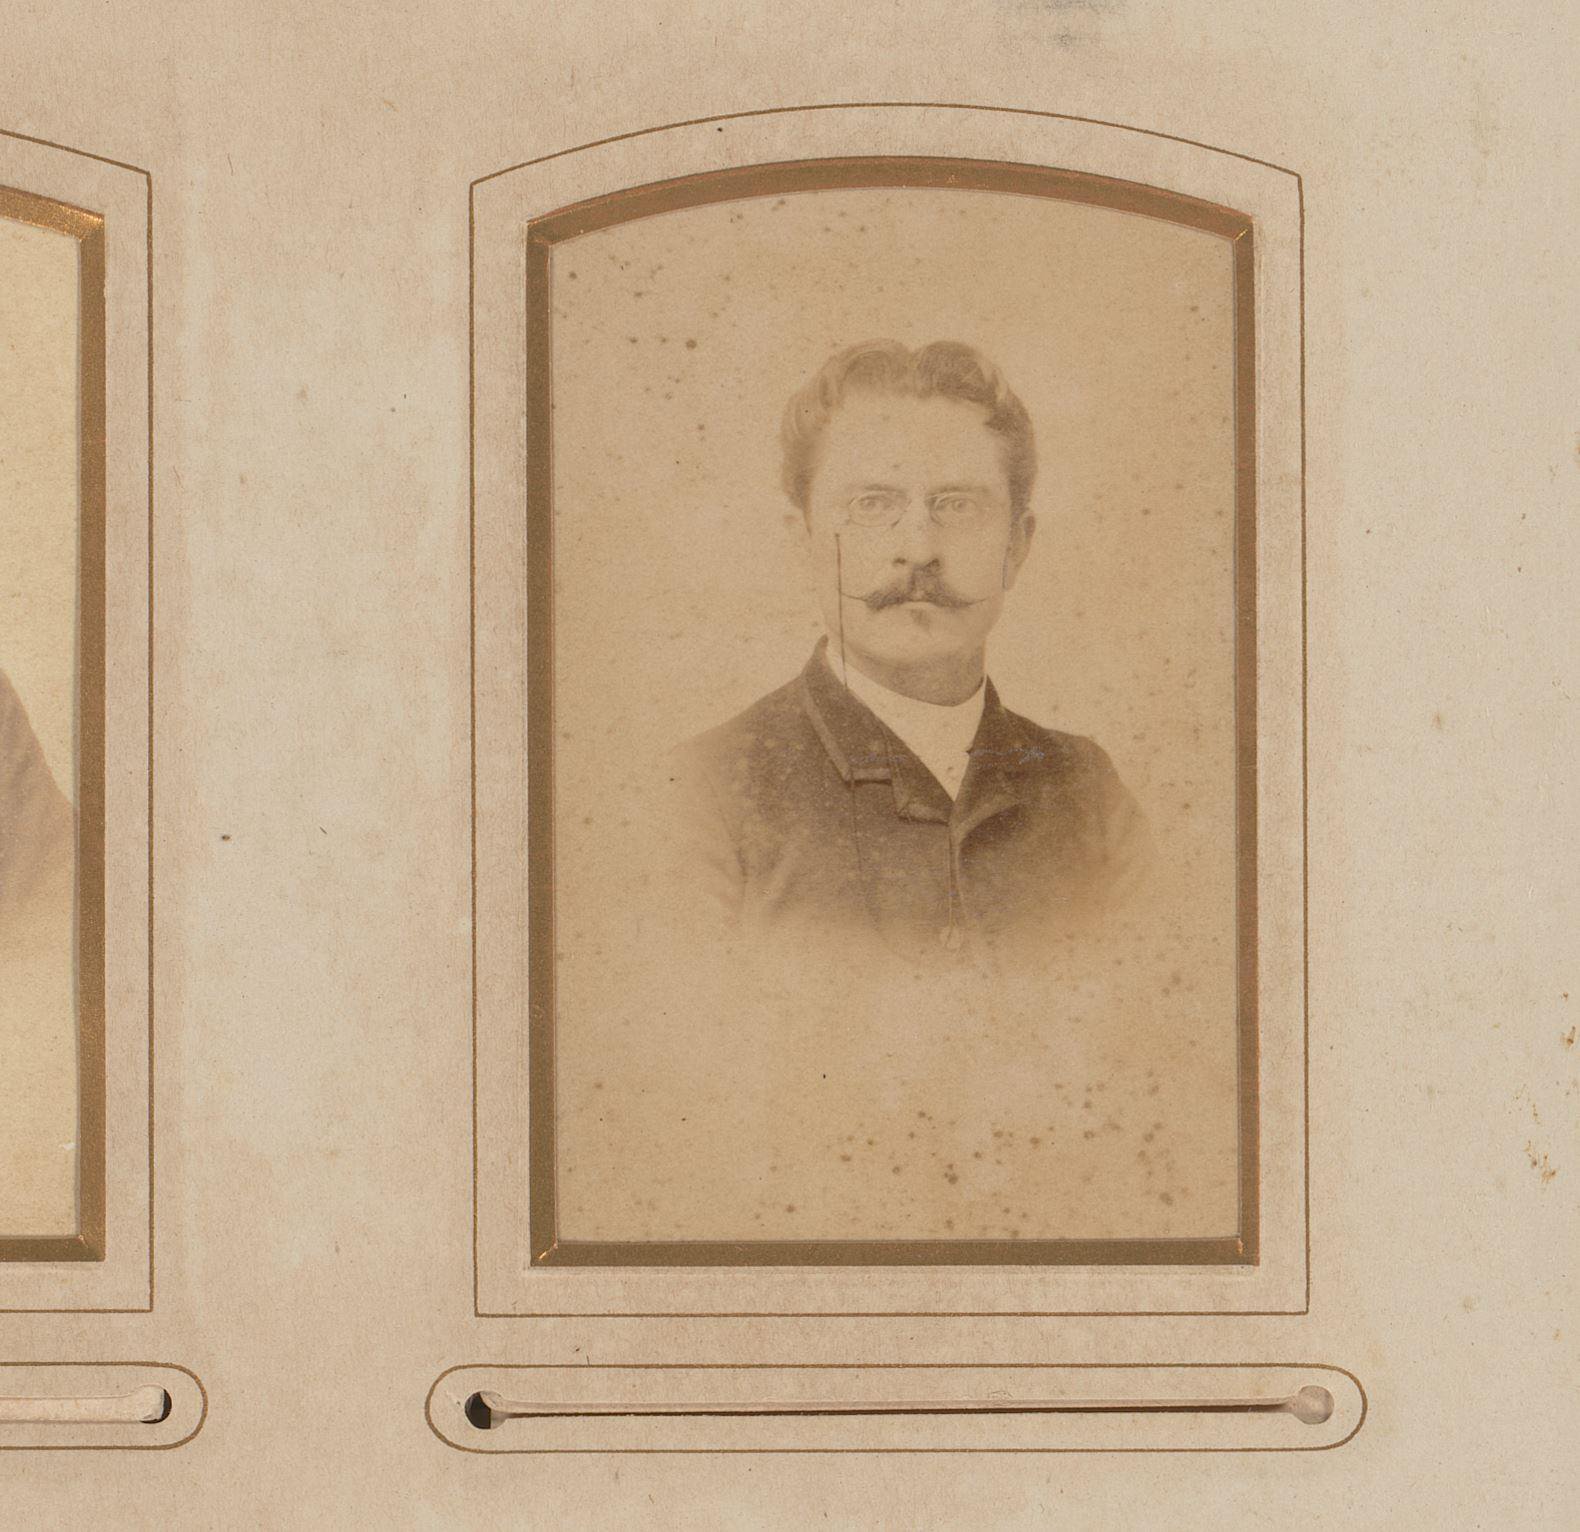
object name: carte de visite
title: Portret van een man met snor en bril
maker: wilhelm frederick antonius delboy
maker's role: fotograaf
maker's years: 1853-1928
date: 1887-1900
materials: cardboard, photographic support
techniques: albumen print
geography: the hague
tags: eyeglasses, spectacles, moustache, historical persons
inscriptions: inscription: ‘Delboy/ Passage 22,/ den Haag.’